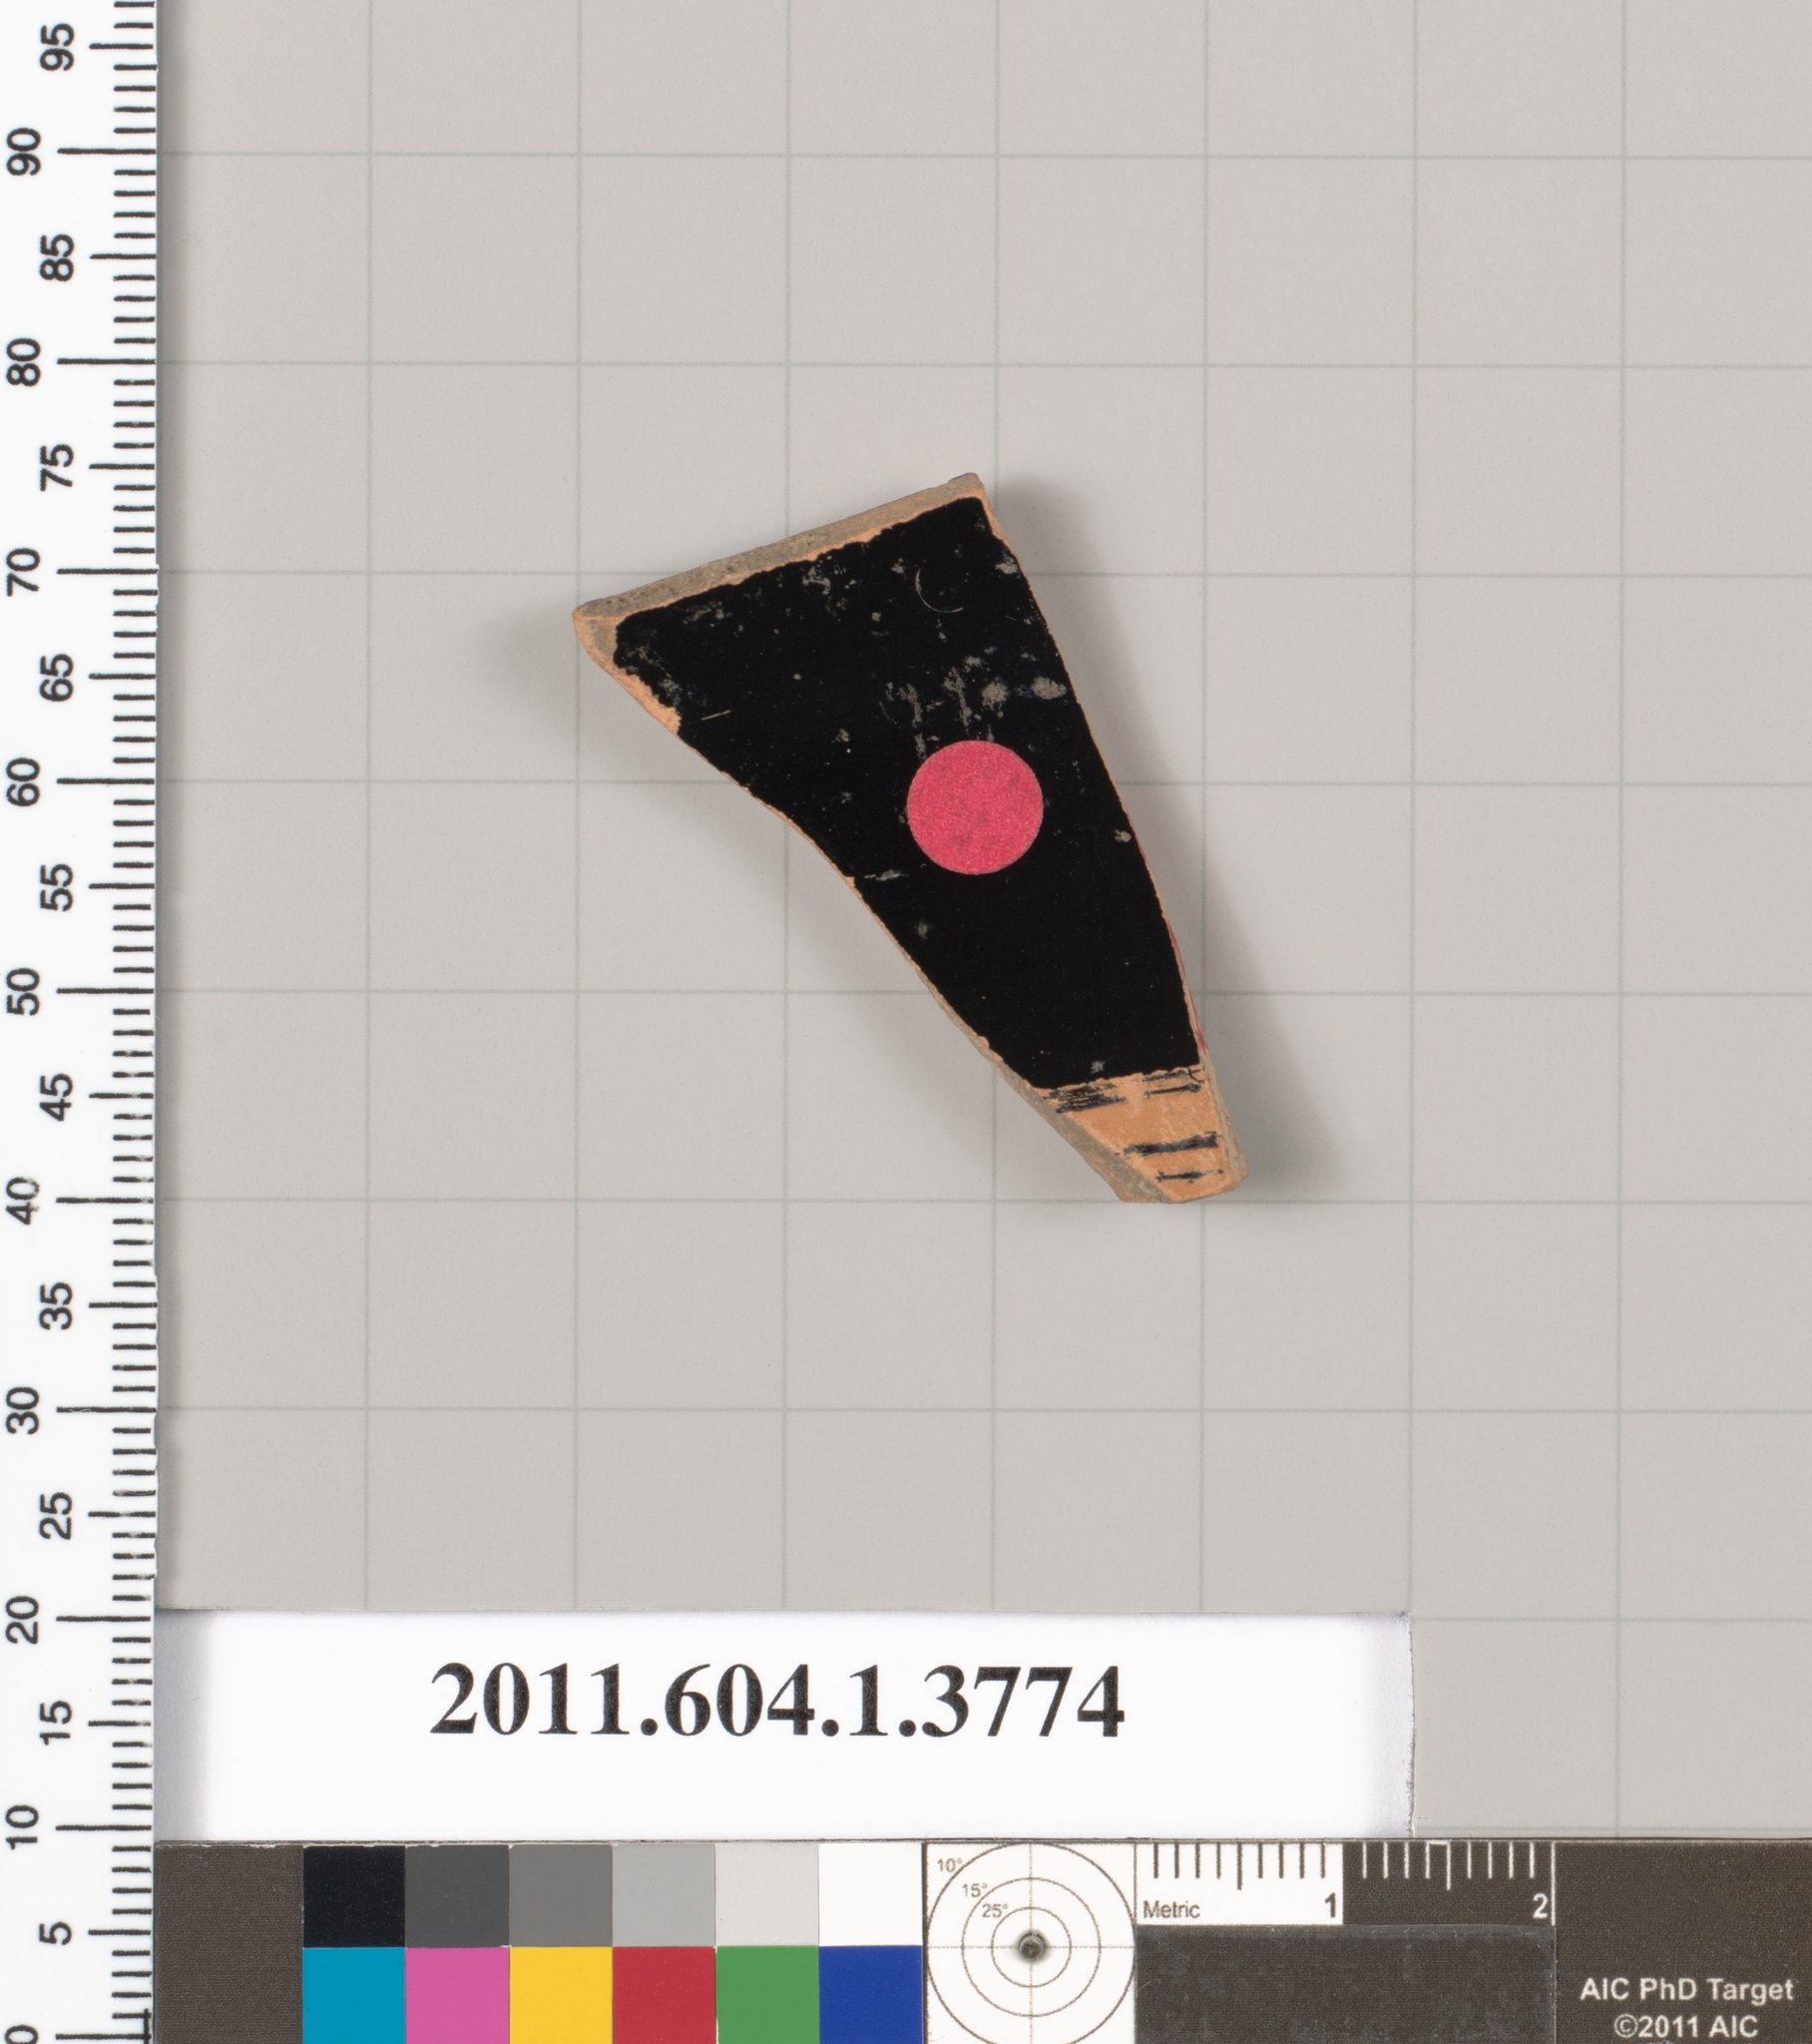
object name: kylix fragment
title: Terracotta fragment of a kylix (drinking cup)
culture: greek, attic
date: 510-480 BCE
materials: terracotta